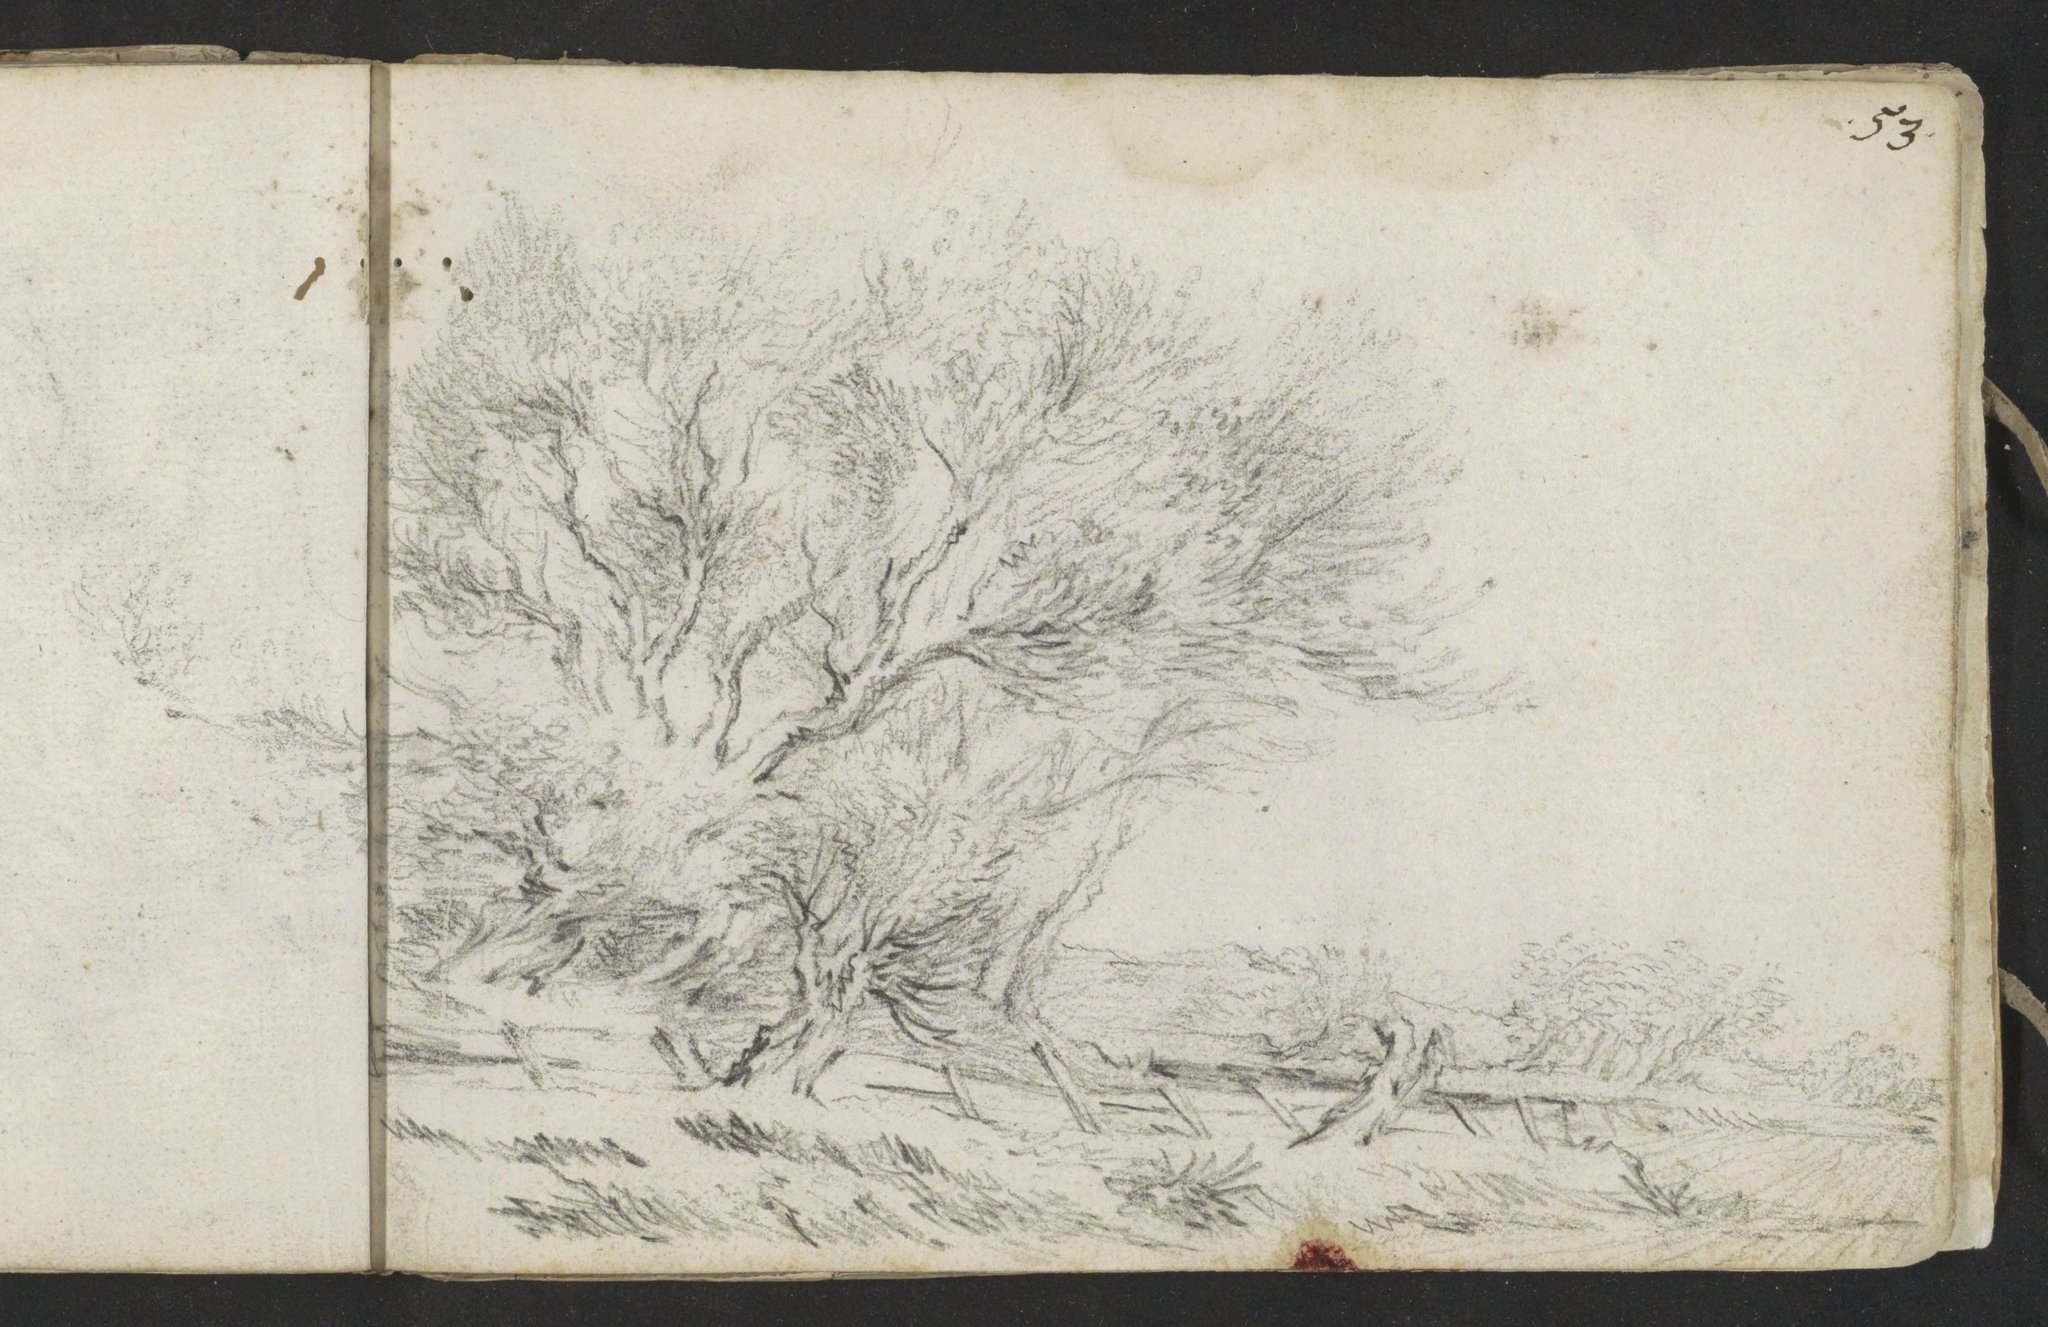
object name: sketchbook leaf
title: Bomen langs een zandpad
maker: gerard ter borch (ii)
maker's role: draughtsman, painter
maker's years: 1617-1681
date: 1634-1635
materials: chalk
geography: haarlem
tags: trees, dunes (sea not visible); in the dunes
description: Blad 53 recto uit een schetsboek met 55 bladen.